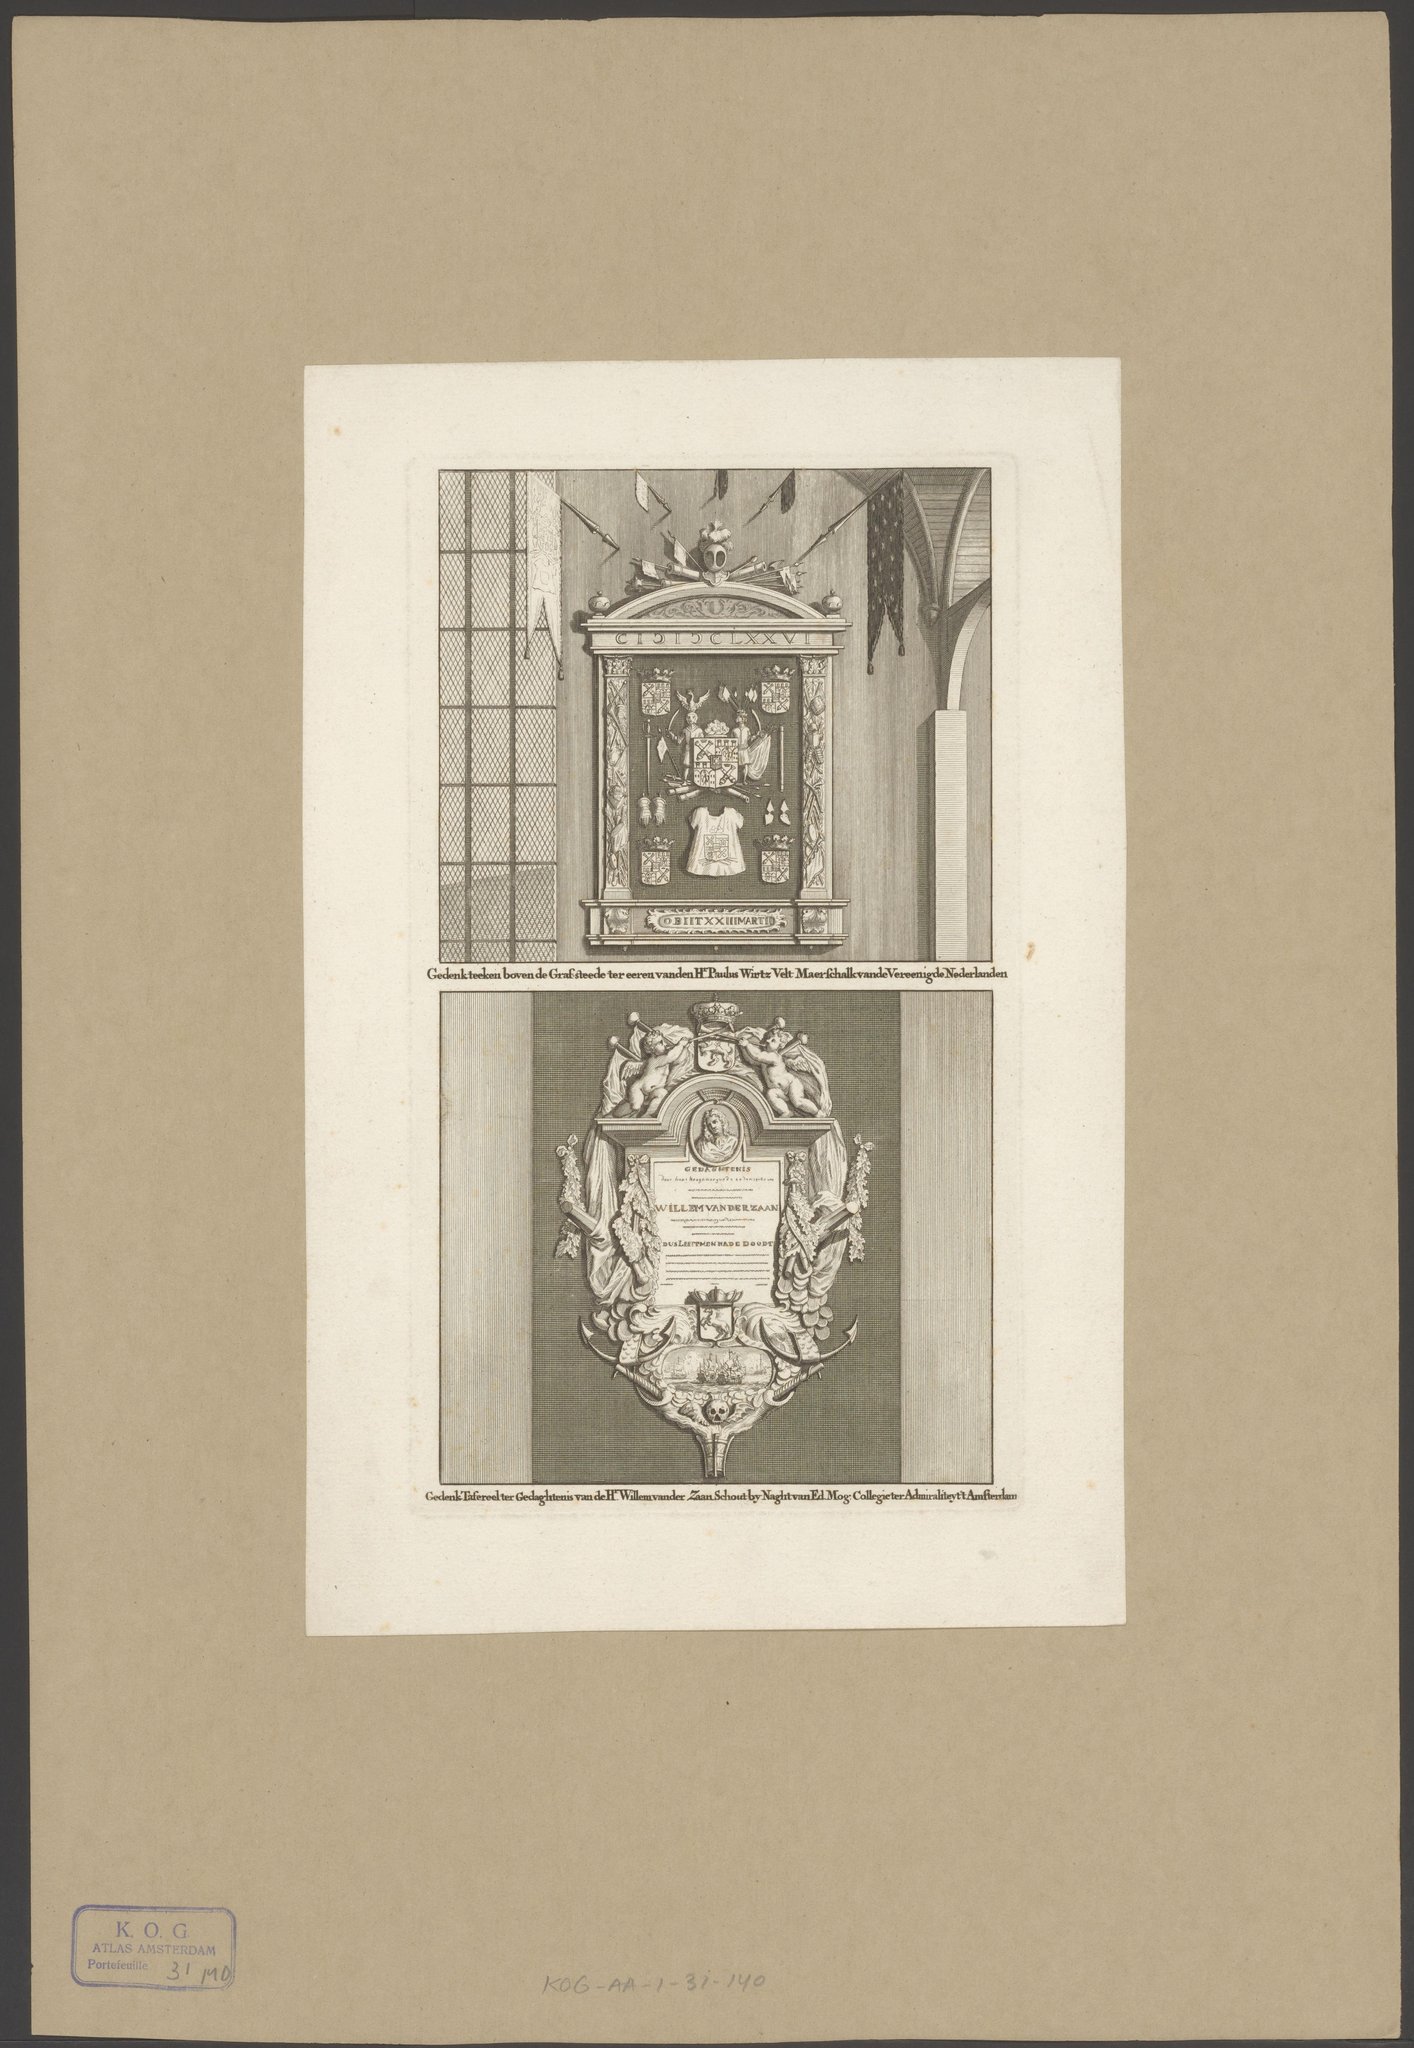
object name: print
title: Gedenkteeken boven de Graf-steede ter eeren vanden Hr. Paulus Wirtz Velt Maerschalk vande Vereenigde Nederlanden / Gedenk Tafereel ter Gedaghtenis van de Hr. Willem vander Zaan Schout by Naght van Ed. Mog. Collegie ter Admiraliteyt ’t Amsterdam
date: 1693-1726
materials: paper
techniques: engraving, etching, letterpress printing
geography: amsterdam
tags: niche-tomb, wall-tomb, coat of arms (as symbol of the state, etc.) (+ nation; national), armorial bearing, heraldry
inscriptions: collector's mark: ‘31.140’ Lugt 1641b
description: Prent ook gebruikt in: Commelin, Caspar. Beschryvinge van Amsterdam, desselfs eerste oorspronk uyt den Huyse (…). 2 dln. Amsterdam: Abraham Wolfgang, Gillis Janssonius van Waesberge, Johannes Janssonius van Waesberge II, weduwe Dirk Boom I, Hendrick Boom en Rembertus Goethals, 1693. En in: Commelin, Caspar. Beschryvinge van Amsterdam, zynde een naukeurige verhandelinge van desselfs eerste oorspronk uyt (…). 2 dln. Amsterdam: weduwe Aart Dircksz Oossaan, 1694. En in: Commelin, Caspar. Beschryvinge van Amsterdam, zynde een naukeurige verhandelinge van desselfs eerste oorspronk uyt (…). 2 delen. 2e druk. Amsterdam: Andries van Damme, Johannes Ratelband, weduwe A. van Aaltwyk en Hermanus Uytwerf, 1726. Deze prent is ook ingebonden in enkele exemplaren van: Wagenaar, Jan. Amsterdam, in zyne opkomst, aanwas, geschiedenissen (…). 3 dln [folio-uitgave]. Amsterdam: Isaak Tirion en Yntema & Tieboel, 1760-1767, dl. 2 (Isaak Tirion, 1765). Komt echter niet voor in de lijst met in te binden prenten van deze uitgave (te vinden in dl. 3) - en is er dus ook niet voor bedoeld.